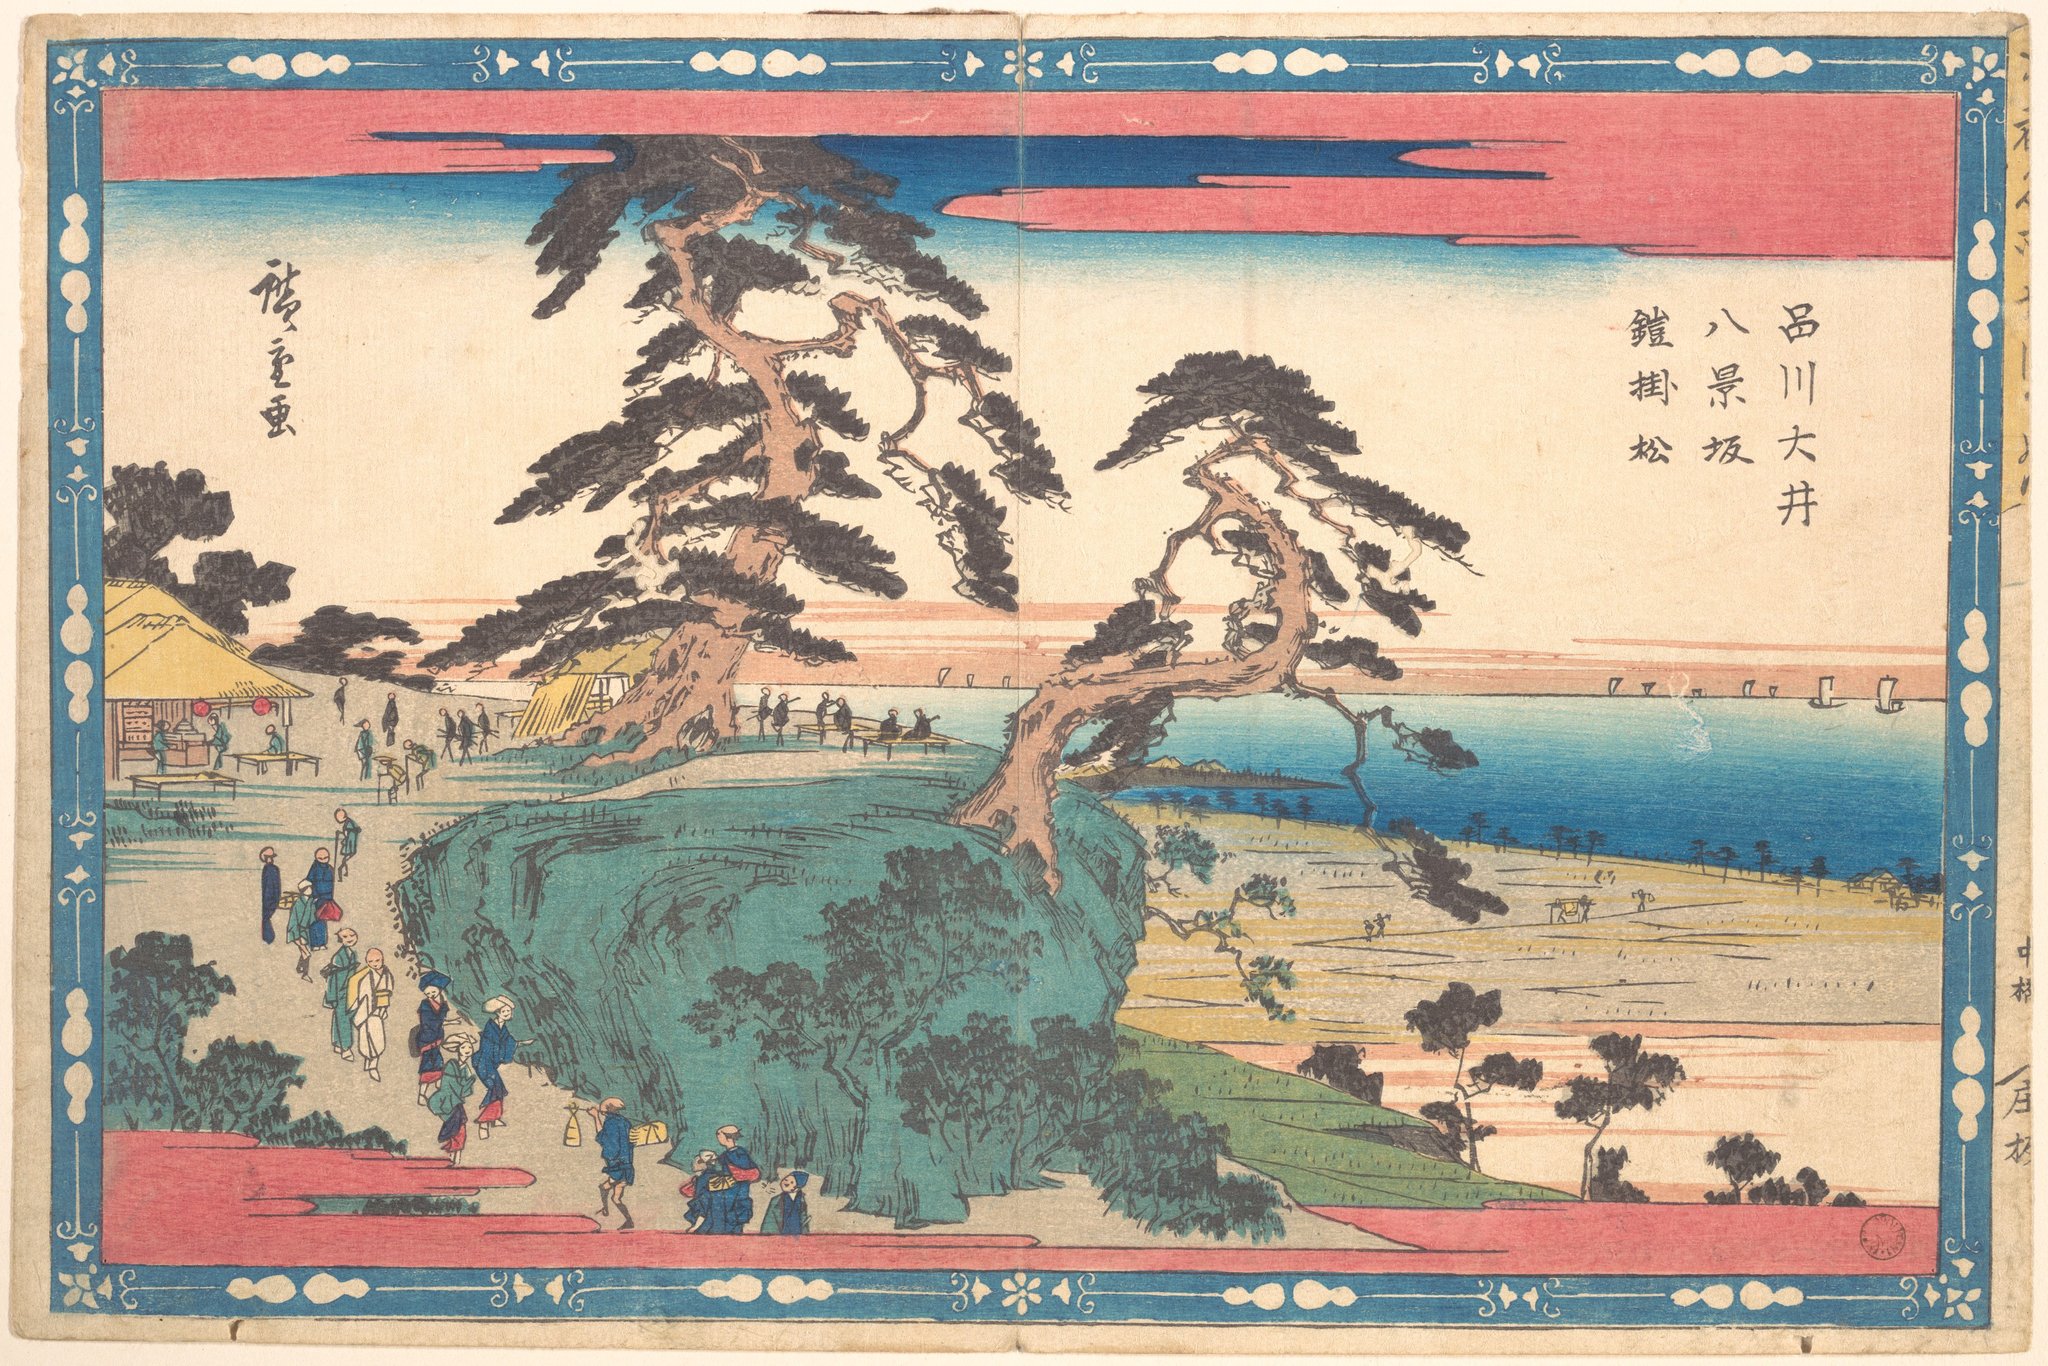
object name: print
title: Shinagawa Hakkei Zaka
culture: japanese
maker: utagawa hiroshige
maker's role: artist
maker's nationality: japanese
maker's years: 1797-1858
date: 1797-1858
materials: ink, paper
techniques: woodblock print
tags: human figures,trees